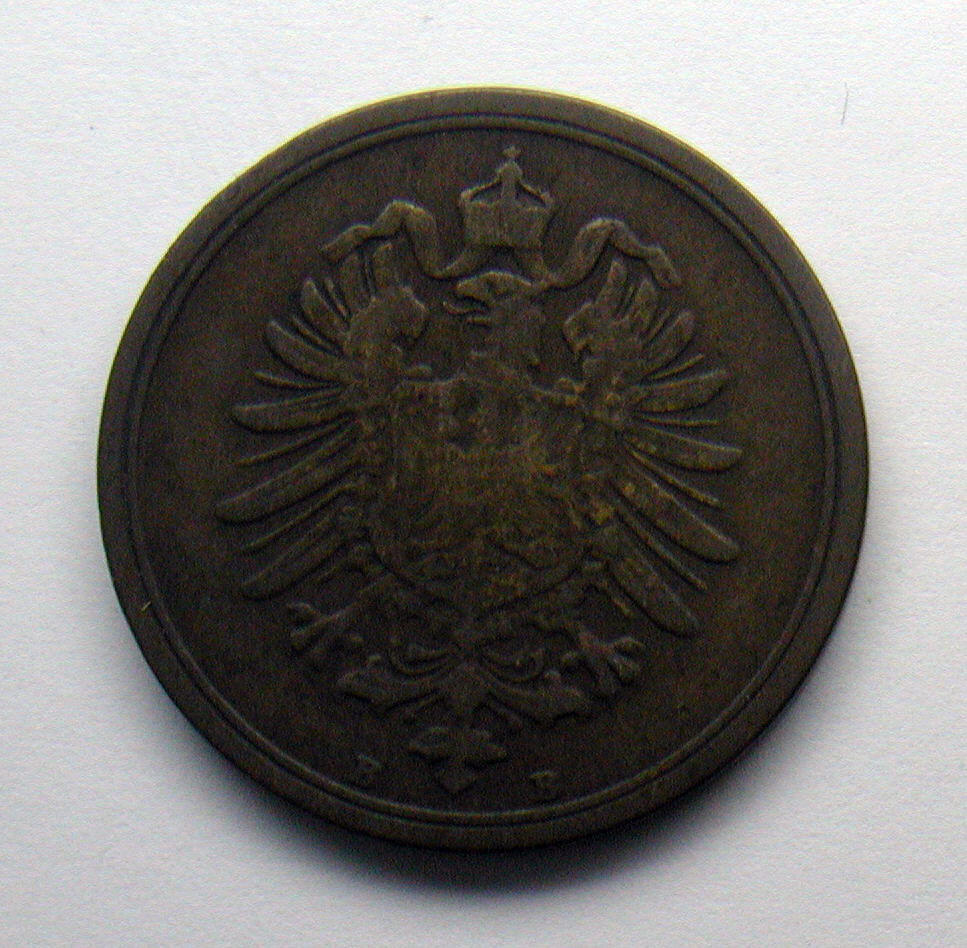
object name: coin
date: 1801-1900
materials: bronze, copper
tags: coat of arms